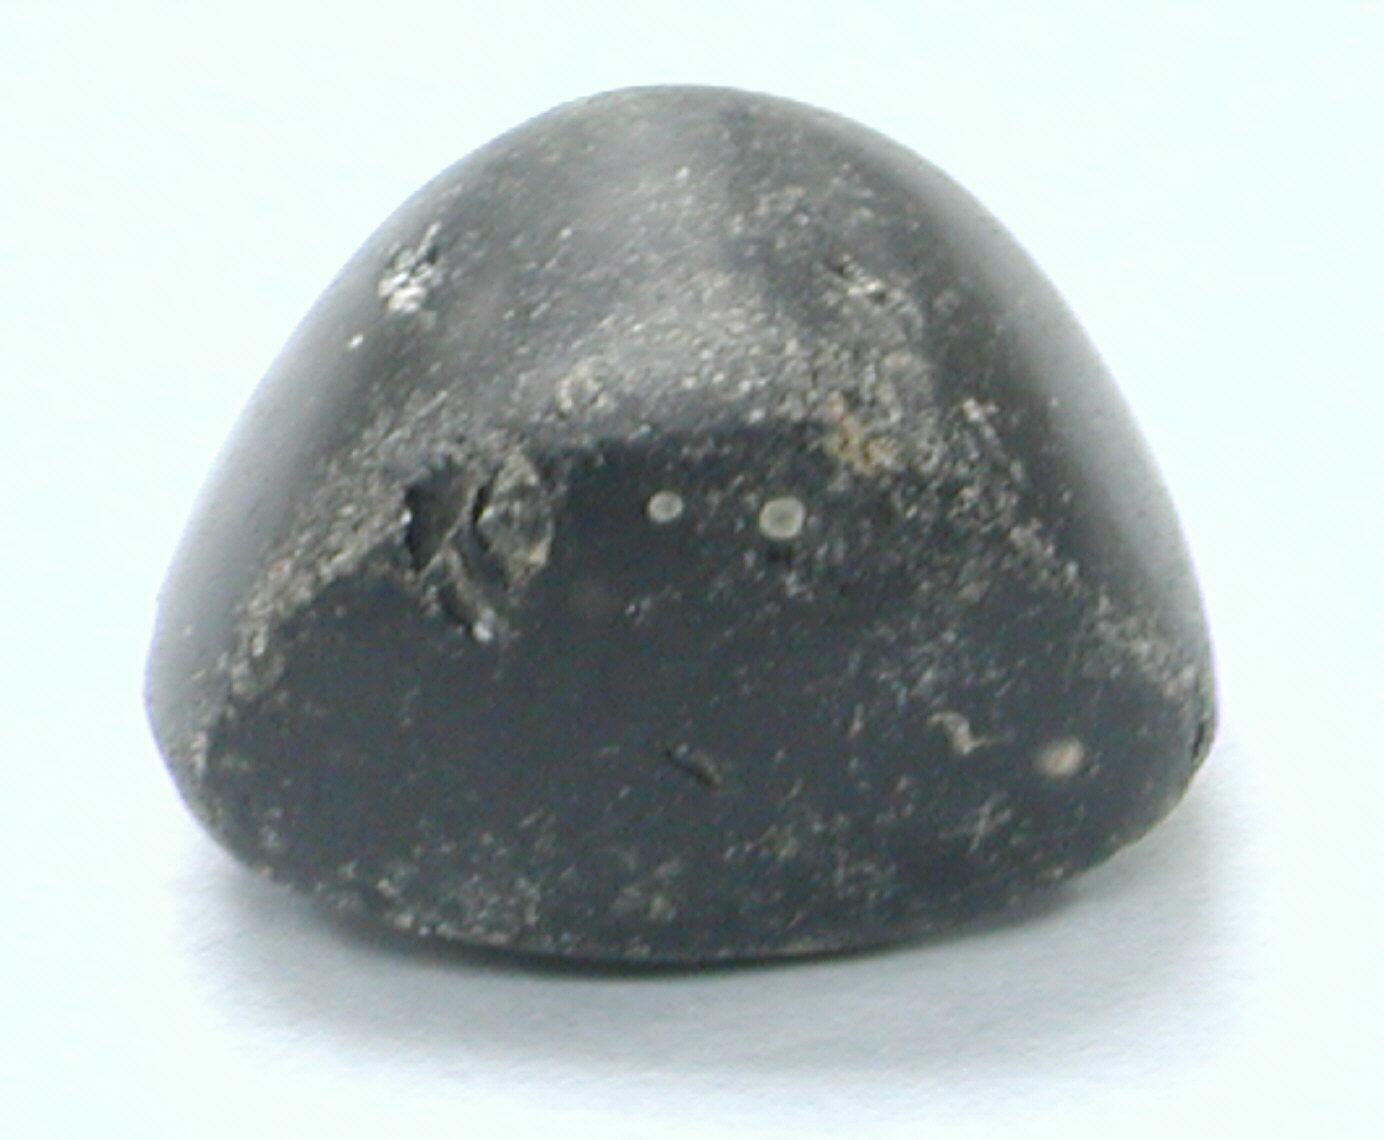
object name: ritual stone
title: Stone Pulidor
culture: mexican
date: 1501-1600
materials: stone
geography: mexico